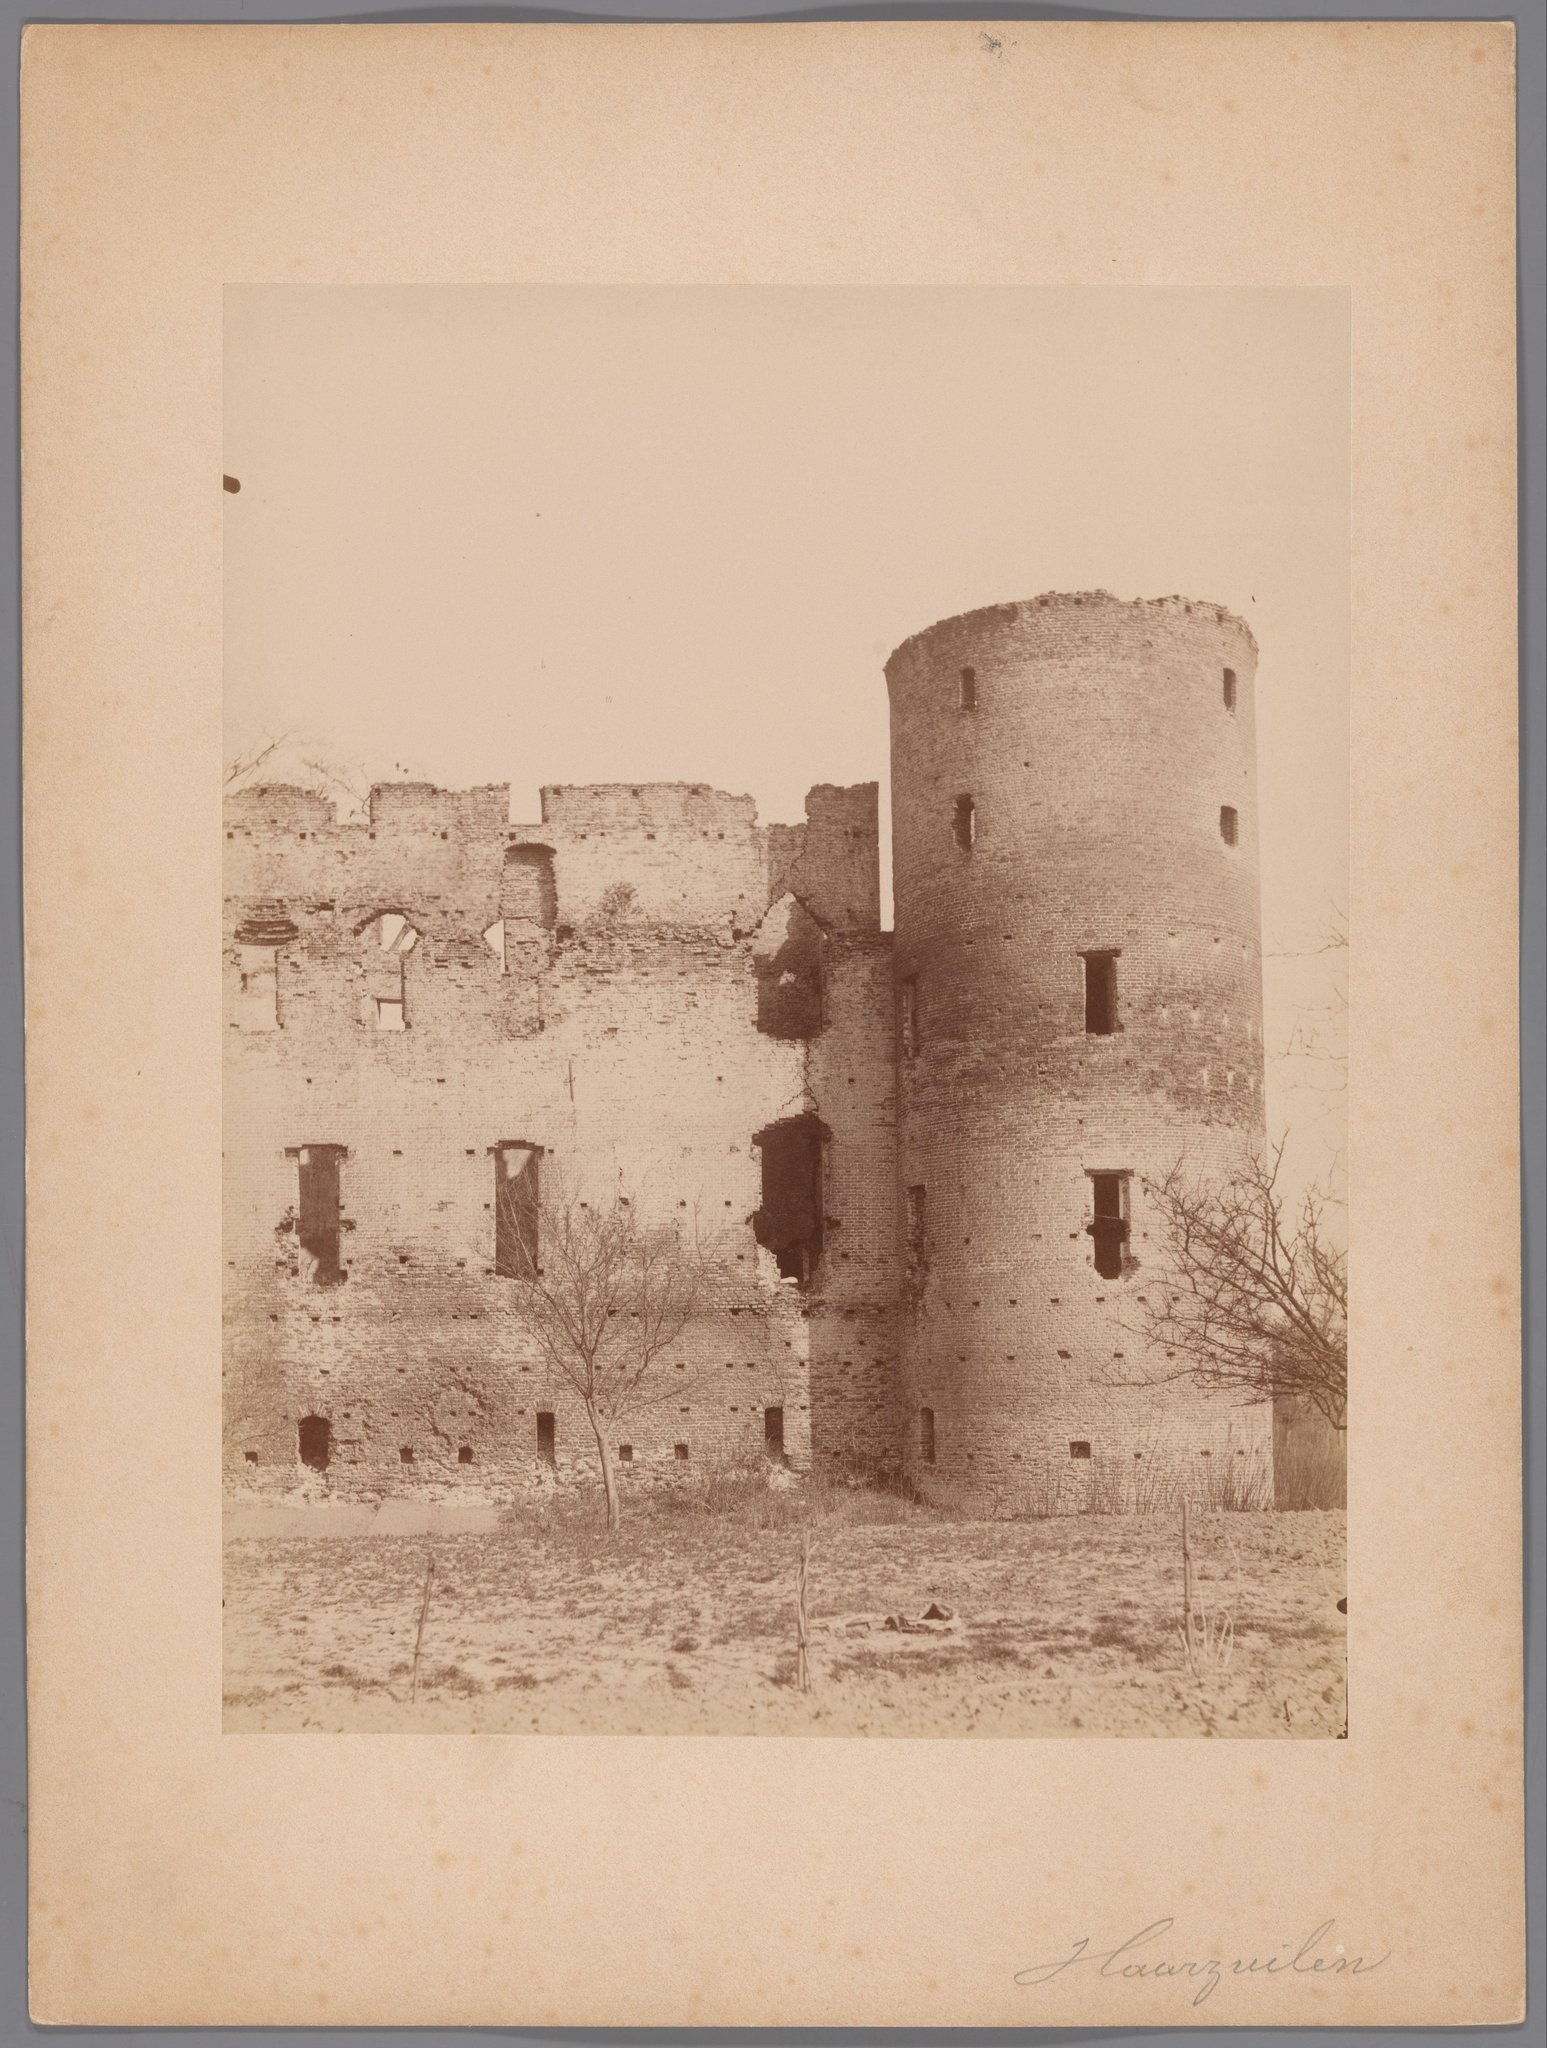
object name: photograph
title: Ruïne van Kasteel de Haar te Haarzuilens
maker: anoniem (monumentenzorg)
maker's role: fotograaf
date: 1885-1892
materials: cardboard, photographic support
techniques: albumen print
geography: haarzuilens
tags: landscape with ruins, ruin of a dwelling, house, castle, etc.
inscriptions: annotation: ‘Huis de Haar/ Ruine’, annotation: ‘Haarzuilen’